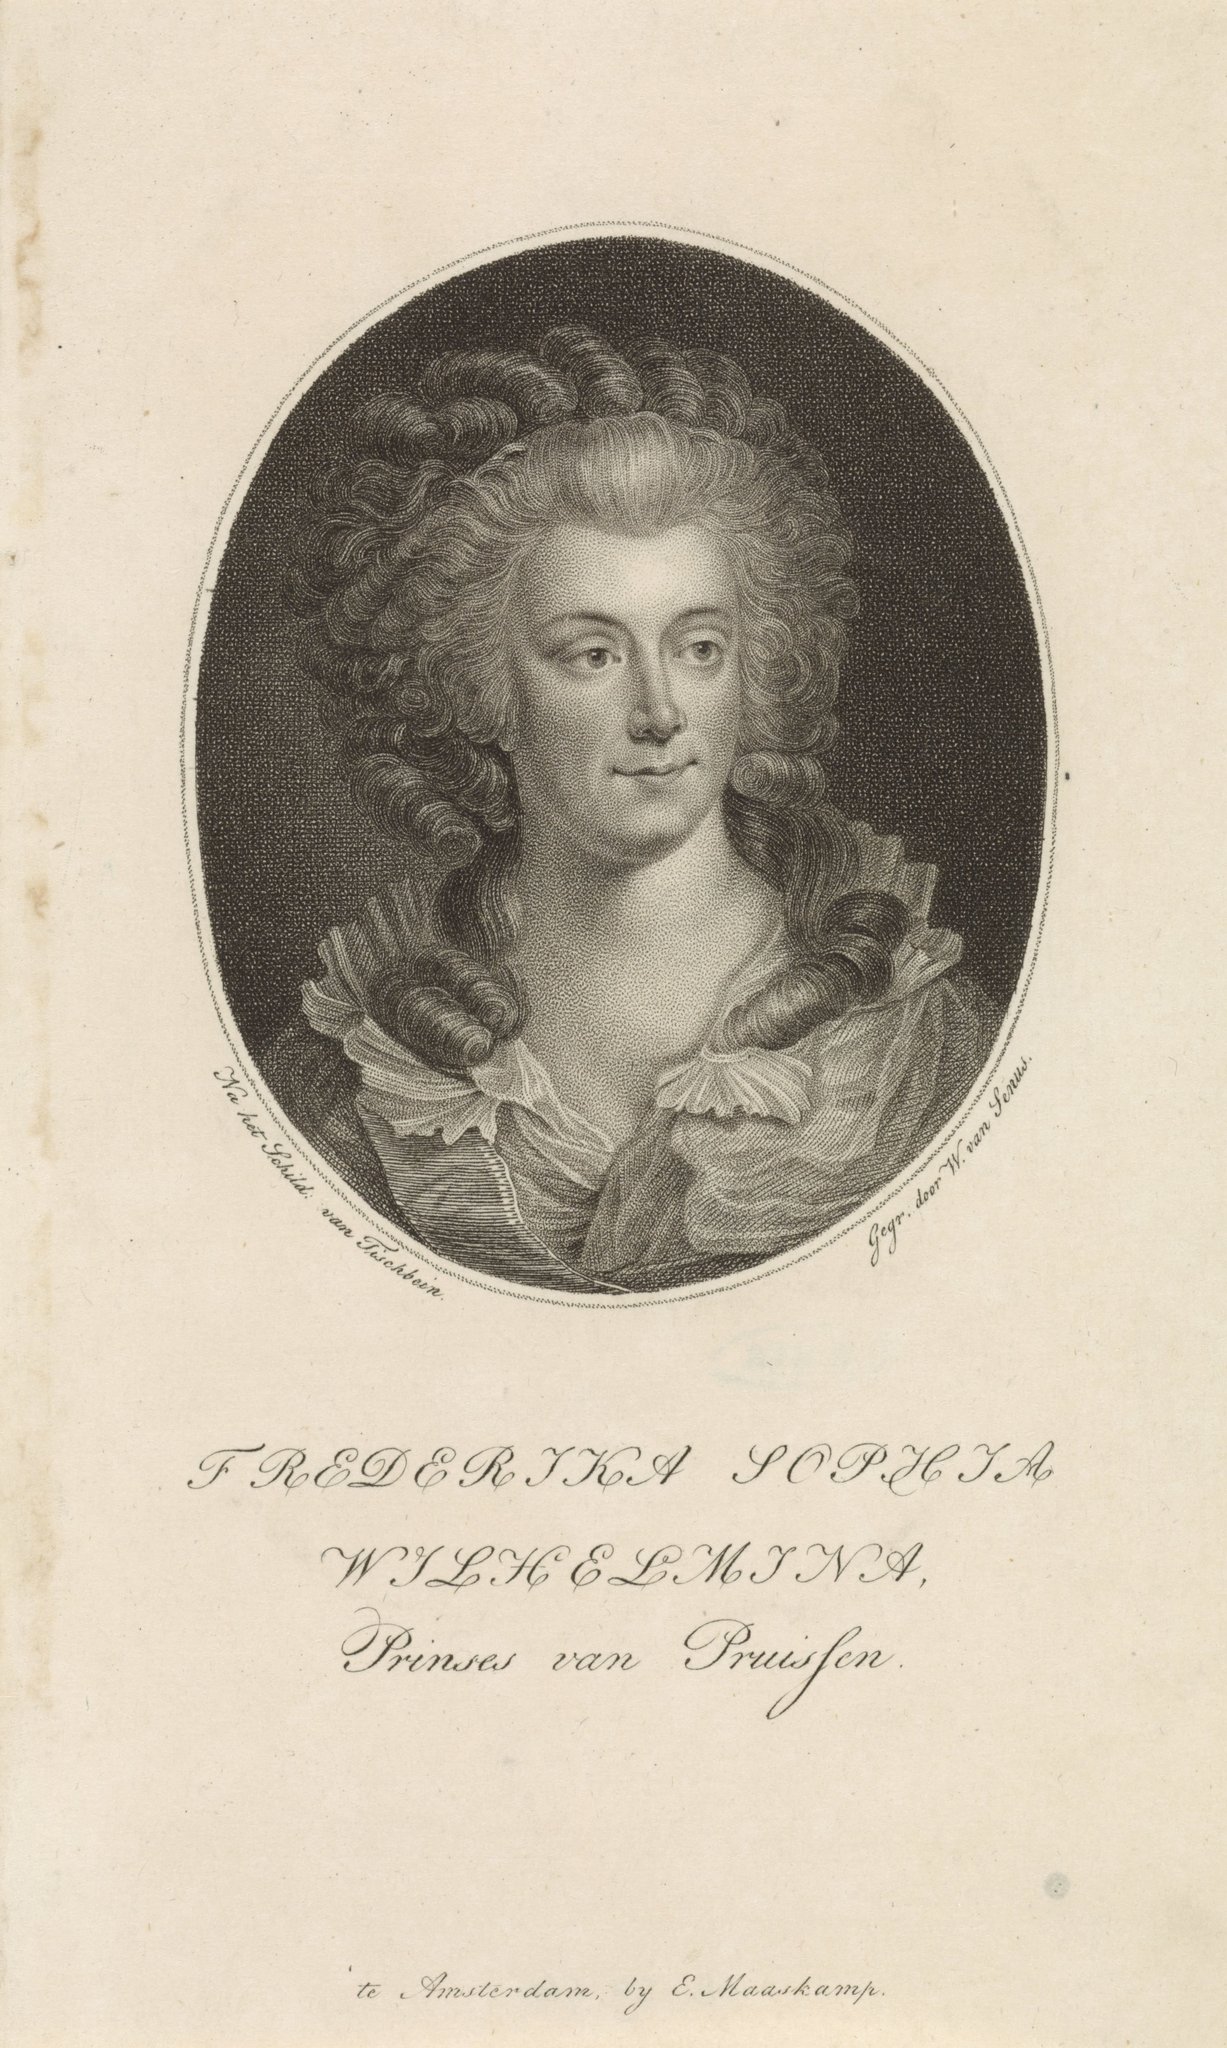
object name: print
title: Portret van Wilhelmina van Pruisen (1751-1820)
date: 1783-1851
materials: paper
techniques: engraving, etching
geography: amsterdam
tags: berlin, painter, draughtsman, wilhelmina of prussia (princess of orange)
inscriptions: collector's mark: Lugt 2228